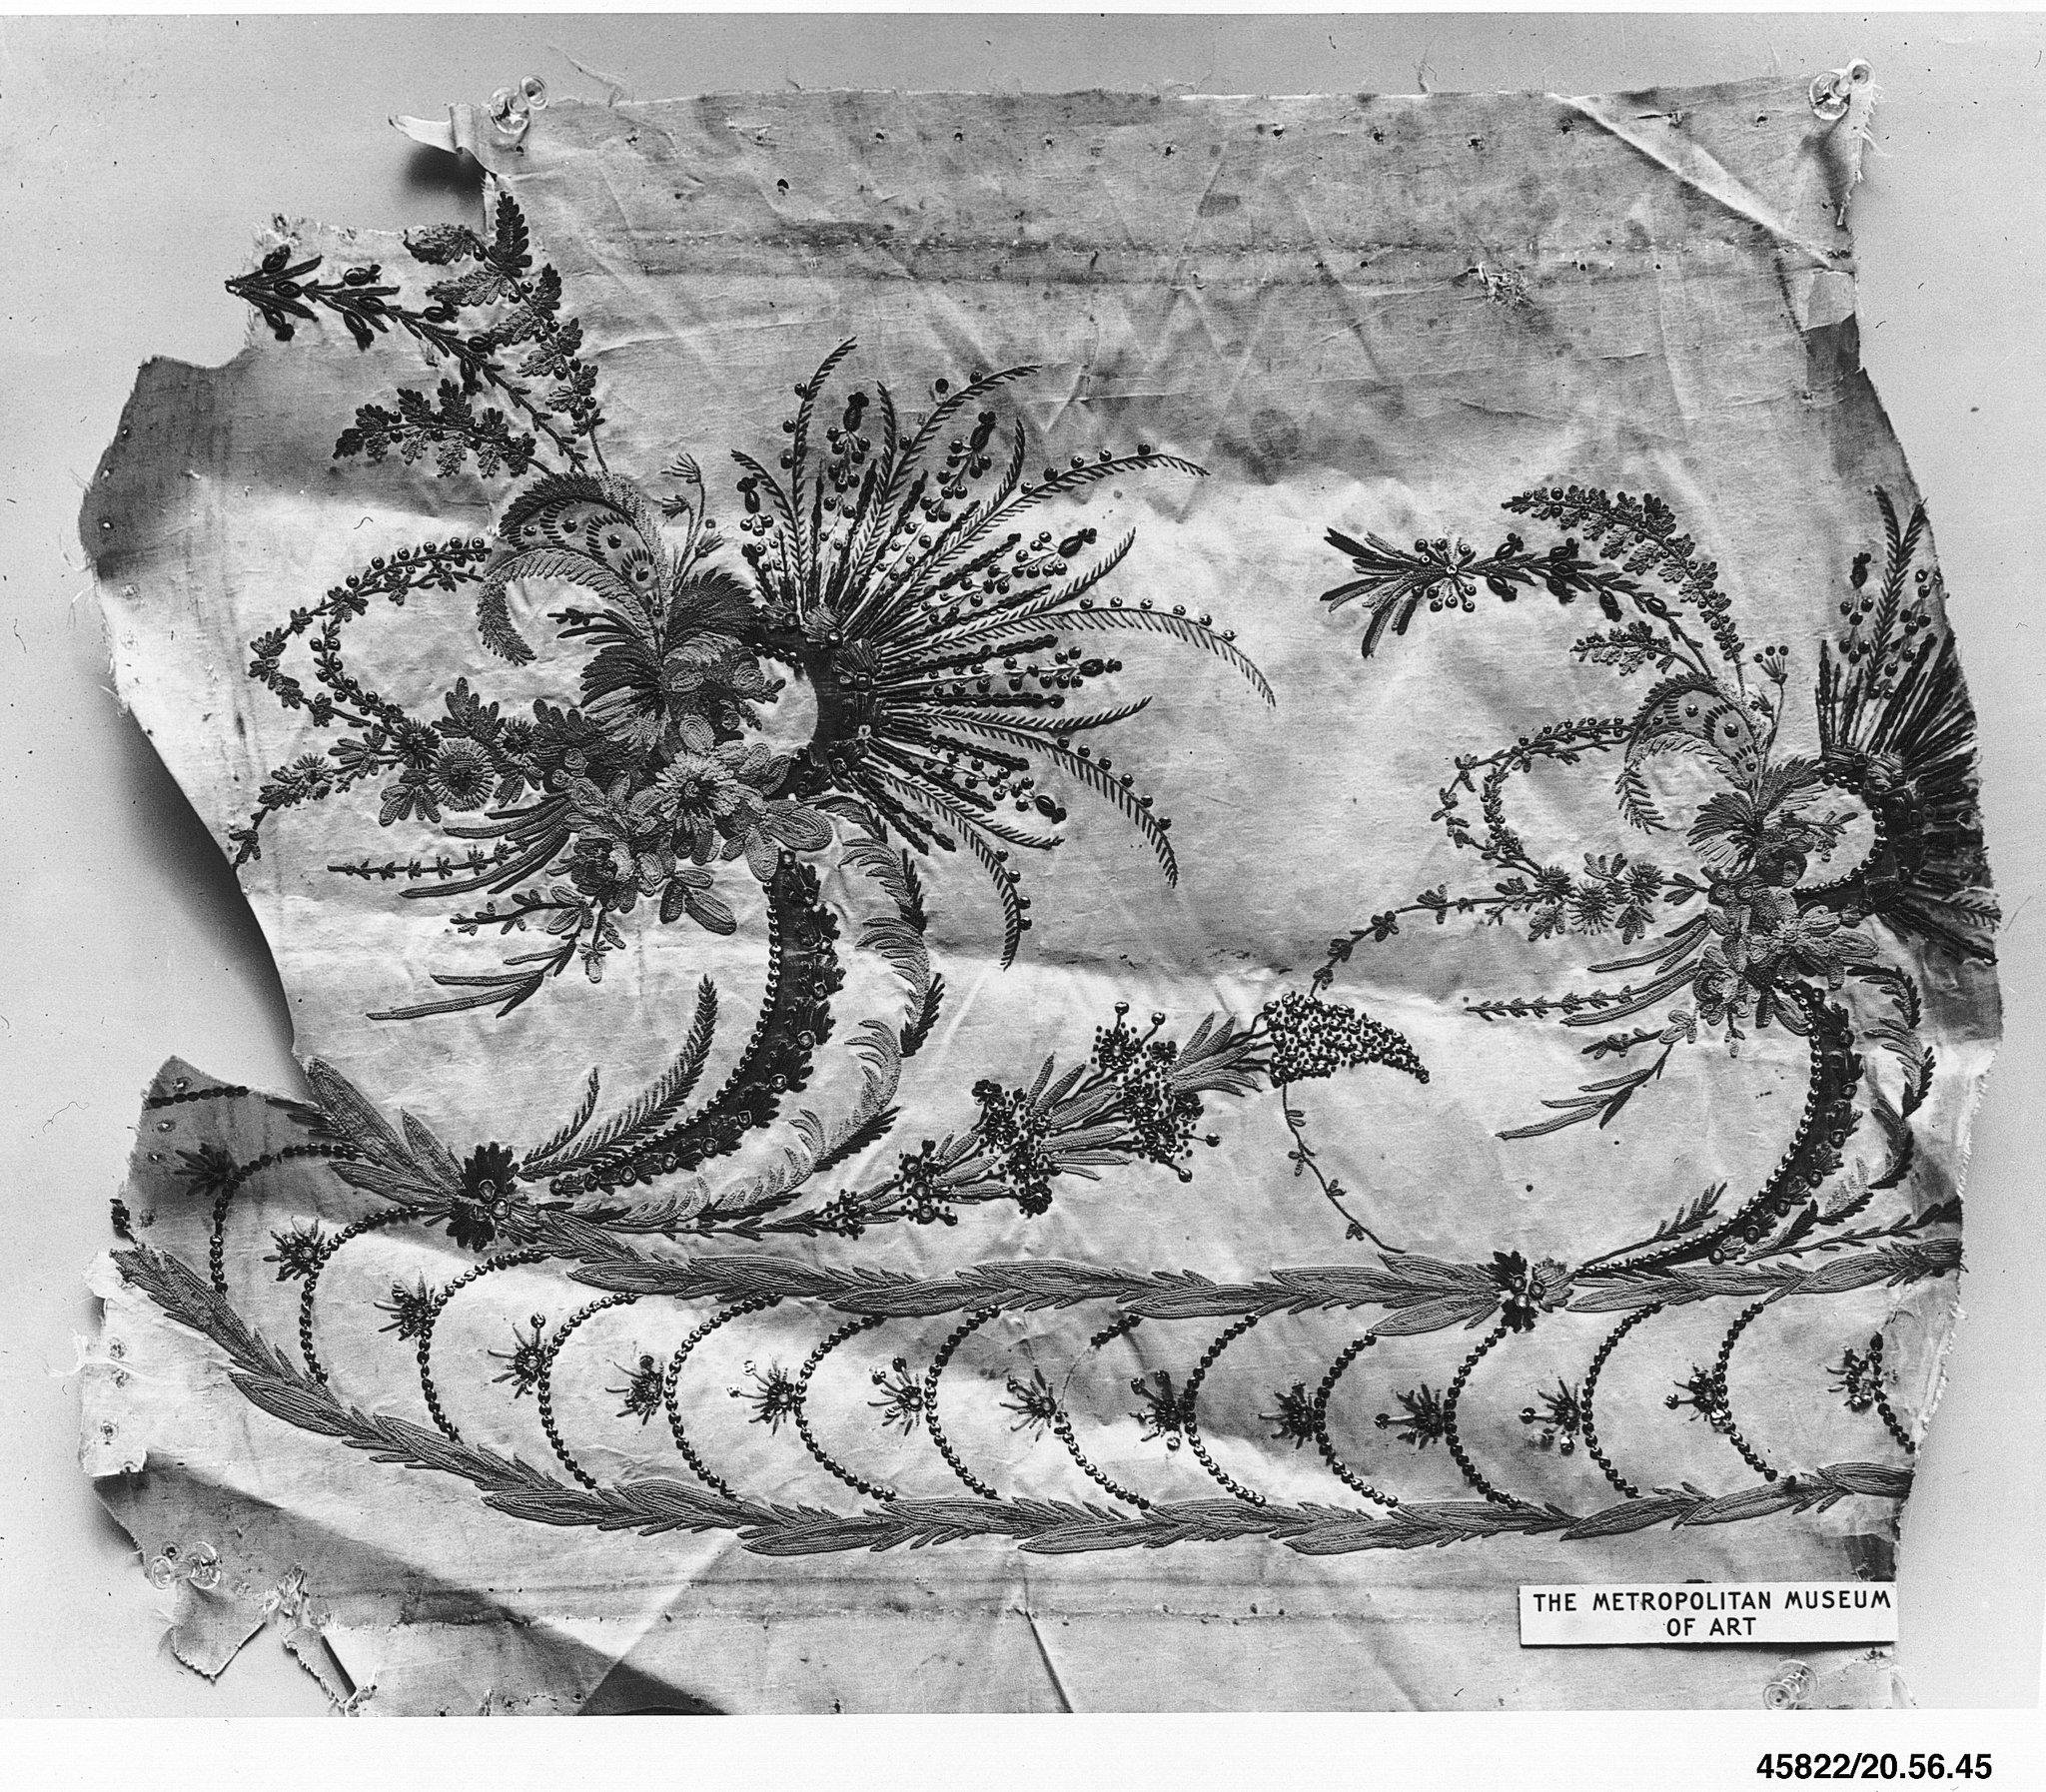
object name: embroidery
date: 1774-1792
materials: metal thread, silk